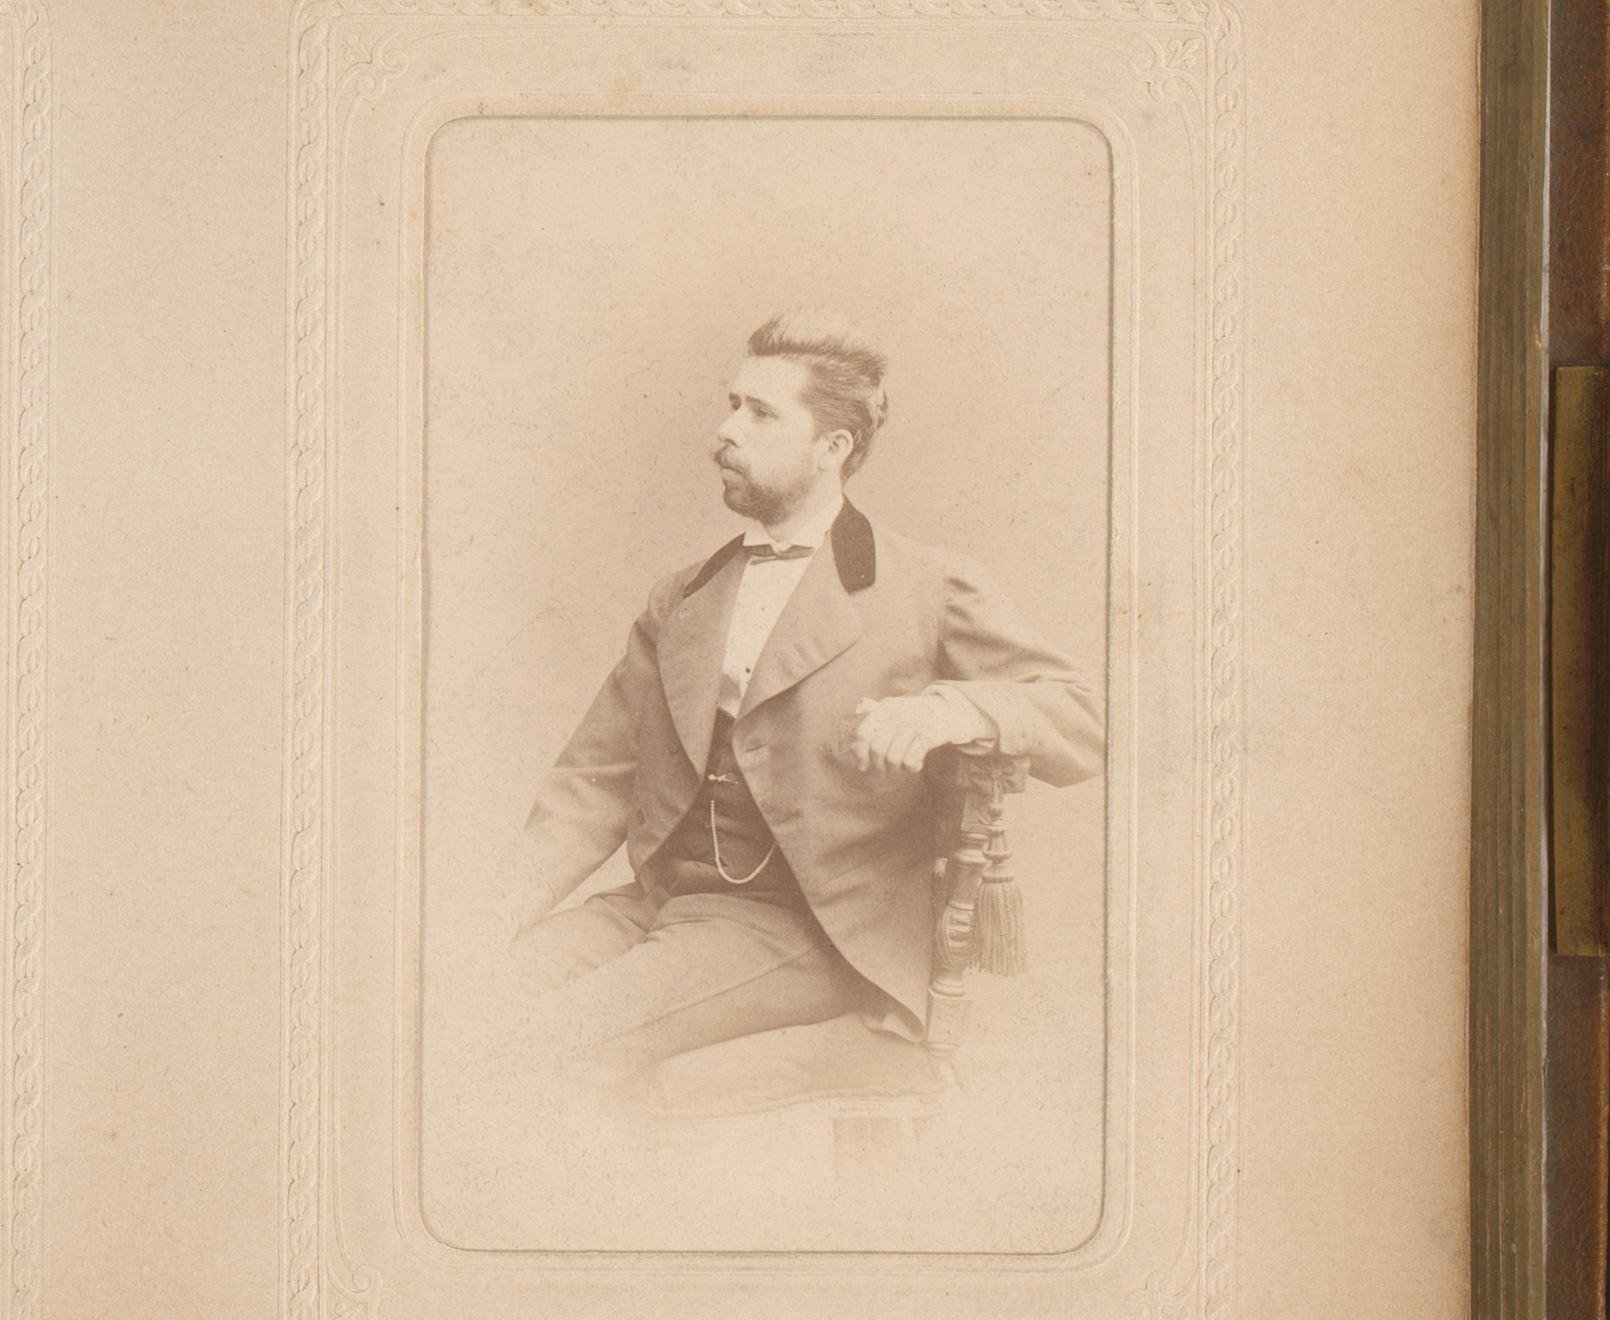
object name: album leaf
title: Portret van een zittende man met snor en baard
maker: hynek fiedler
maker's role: painter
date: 1860-1900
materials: cardboard, photographic support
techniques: albumen print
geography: prague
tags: sitting figure, moustache, historical persons, beard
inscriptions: name: ‘Pr[..]as z’, inscription: ‘H. Fiedler/ Fotograf i malir/ v PRAZE/ 783-II. Václavaské nam cis. 24 nove./ Matrice se zachová.’, annotation: ‘AL Kes’